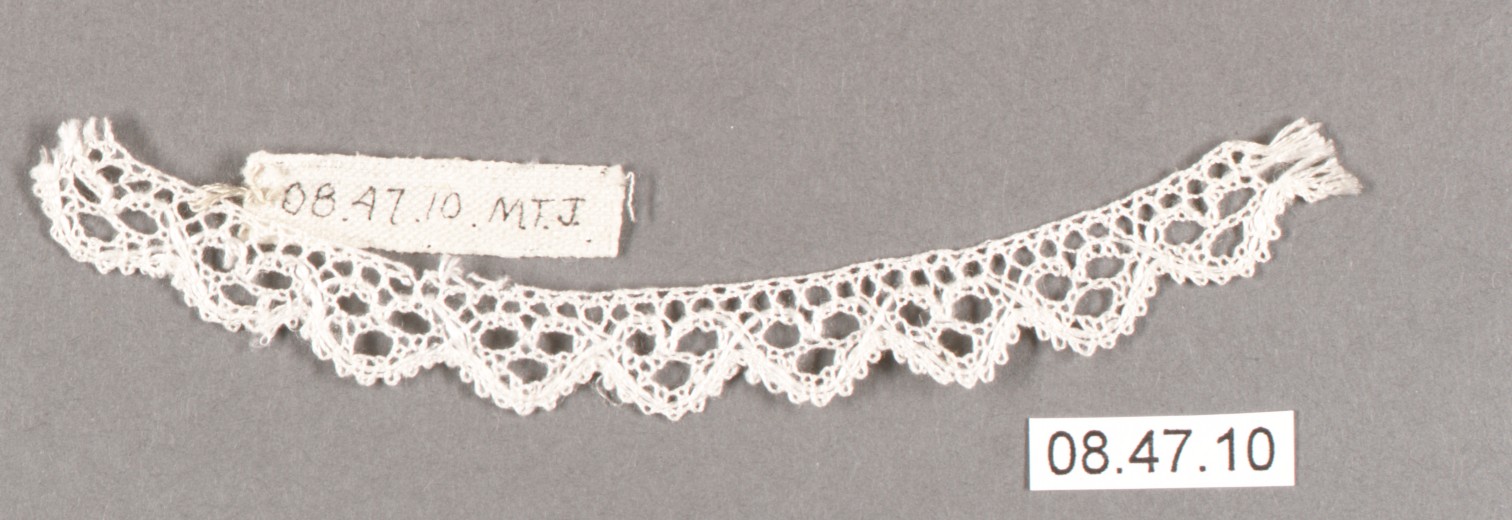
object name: fragment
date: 1801-1900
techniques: lace